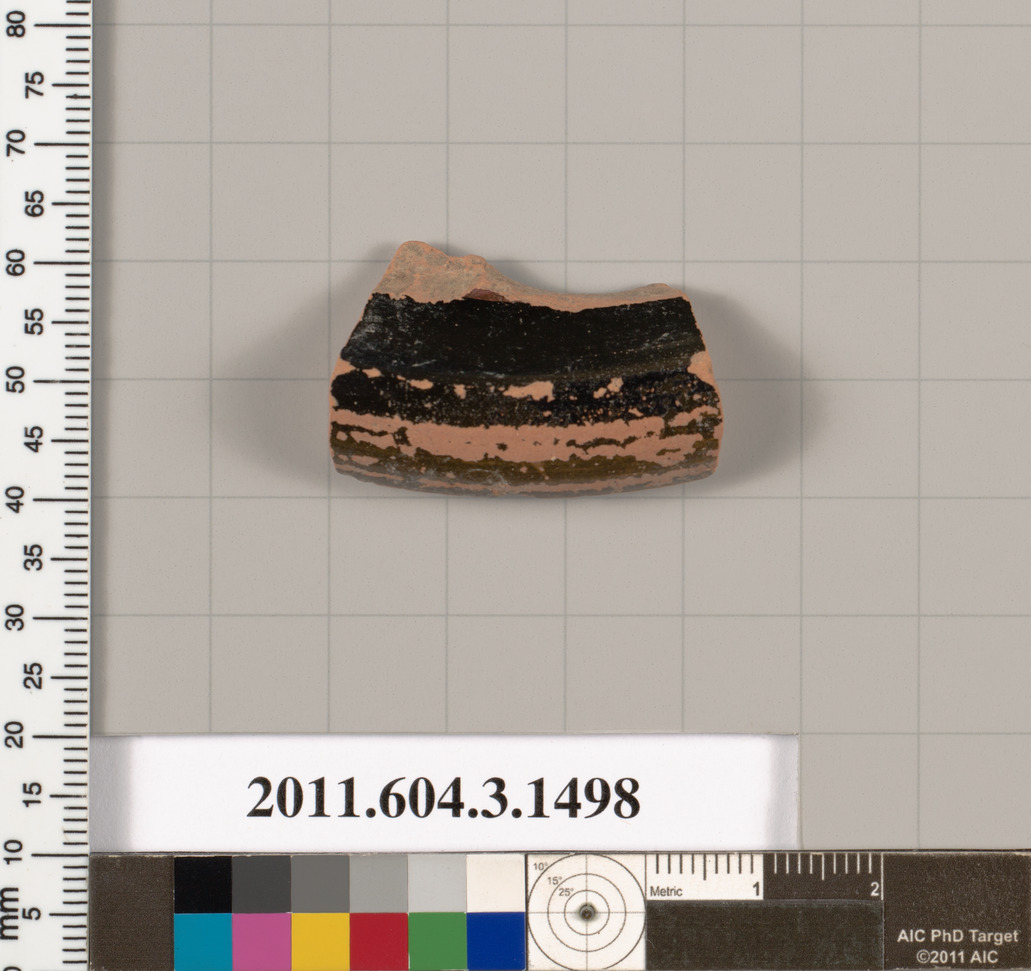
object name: skyphos fragment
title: Terracotta fragment of a skyphos (deep drinking cup)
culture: greek, attic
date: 600-401 BCE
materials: terracotta